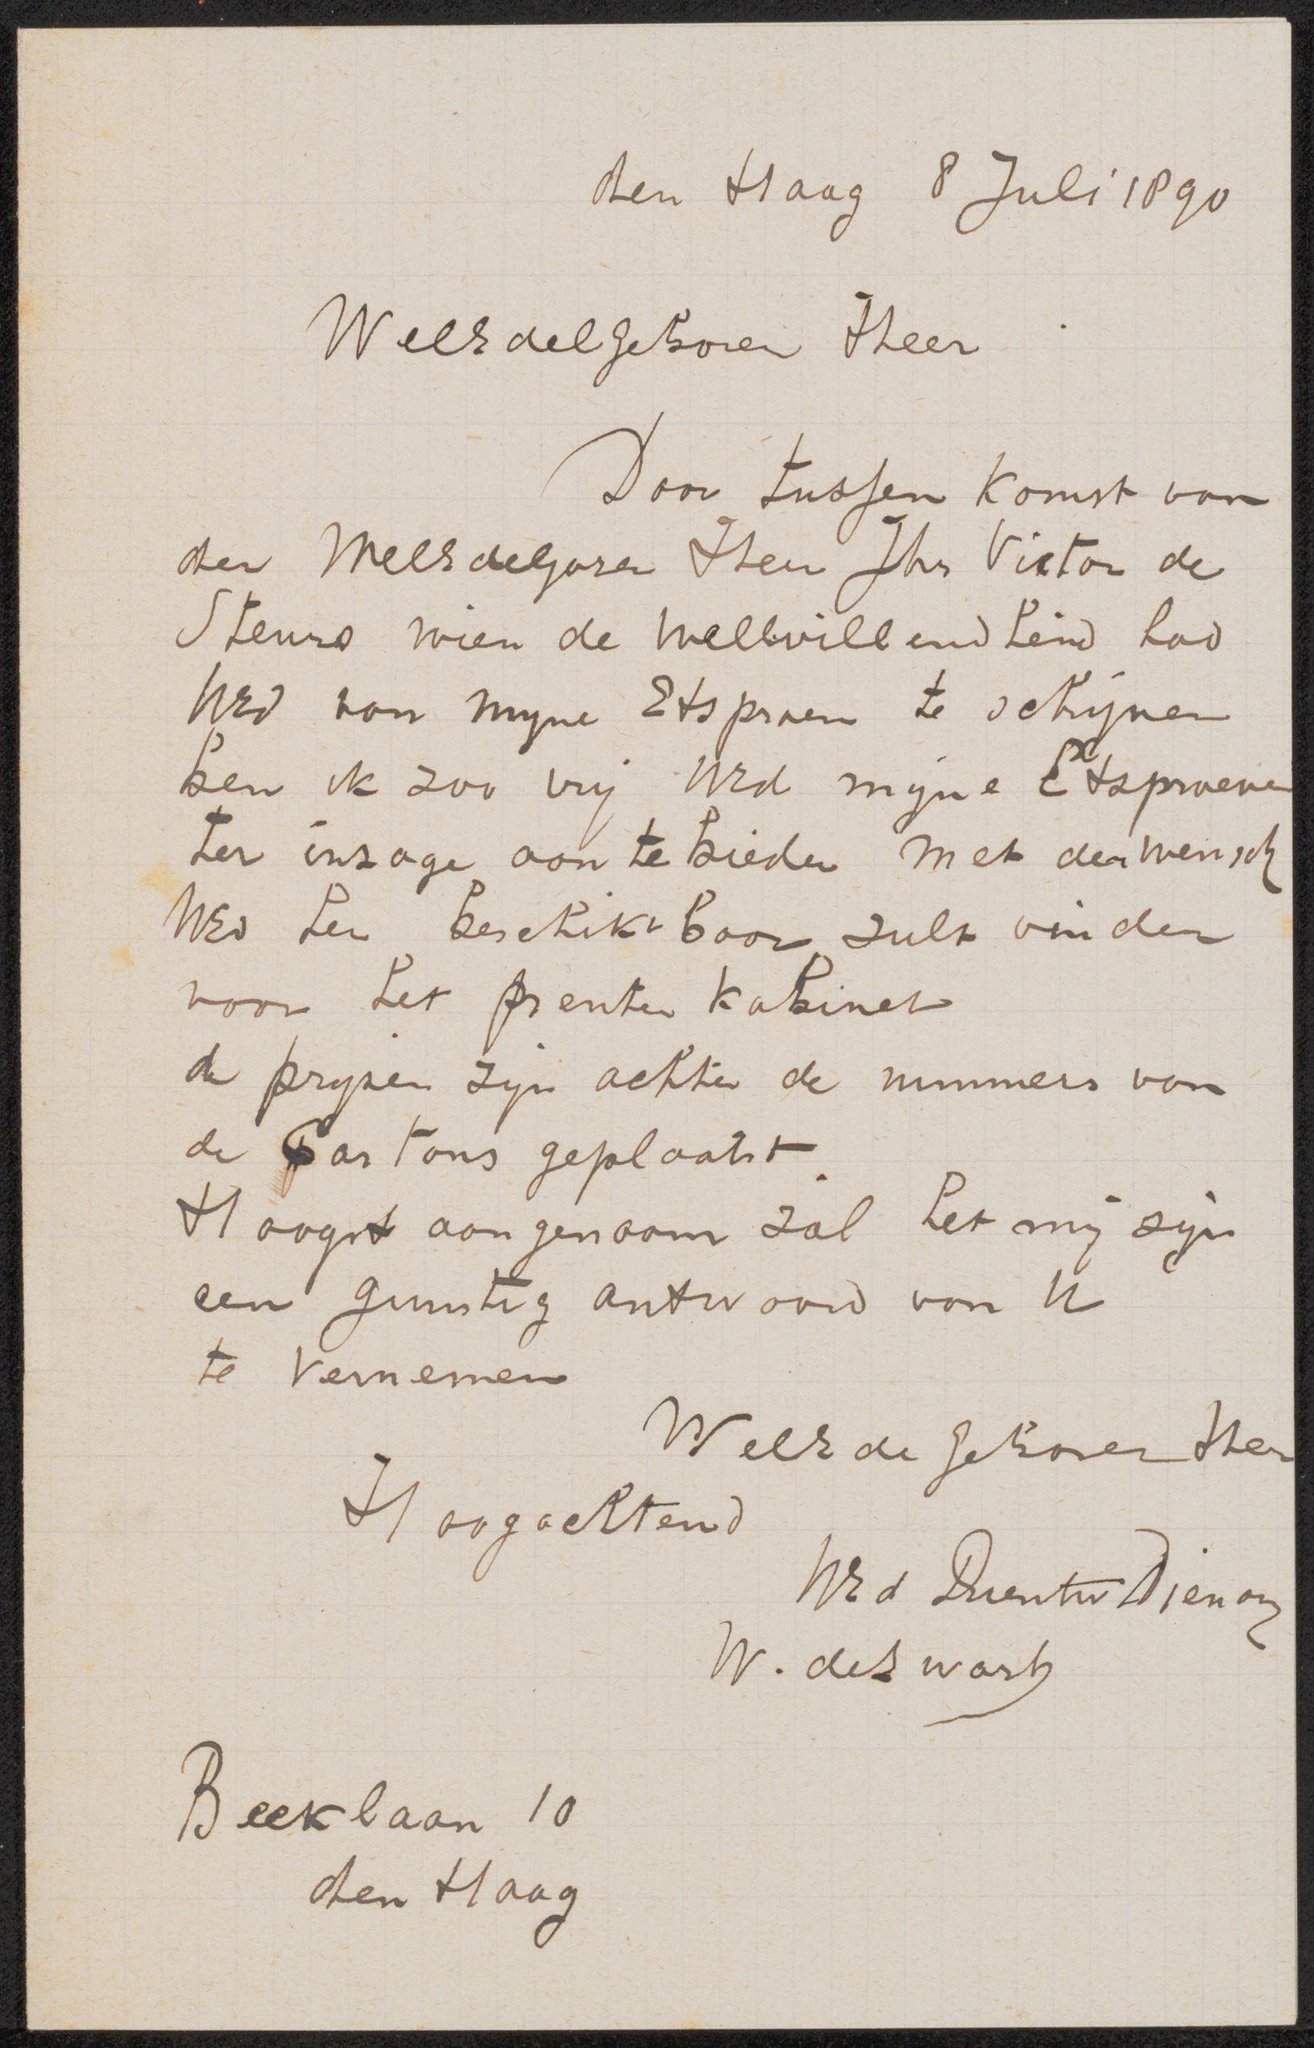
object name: letter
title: Brief aan Johan Philip van der Kellen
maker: willem de zwart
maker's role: draughtsman, painter, print maker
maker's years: 1862-1931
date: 1890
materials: ink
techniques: pen, writing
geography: the hague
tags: utrecht, johan philip van der kellen, jonkheer victor eugène louis de stuers, the graphic arts